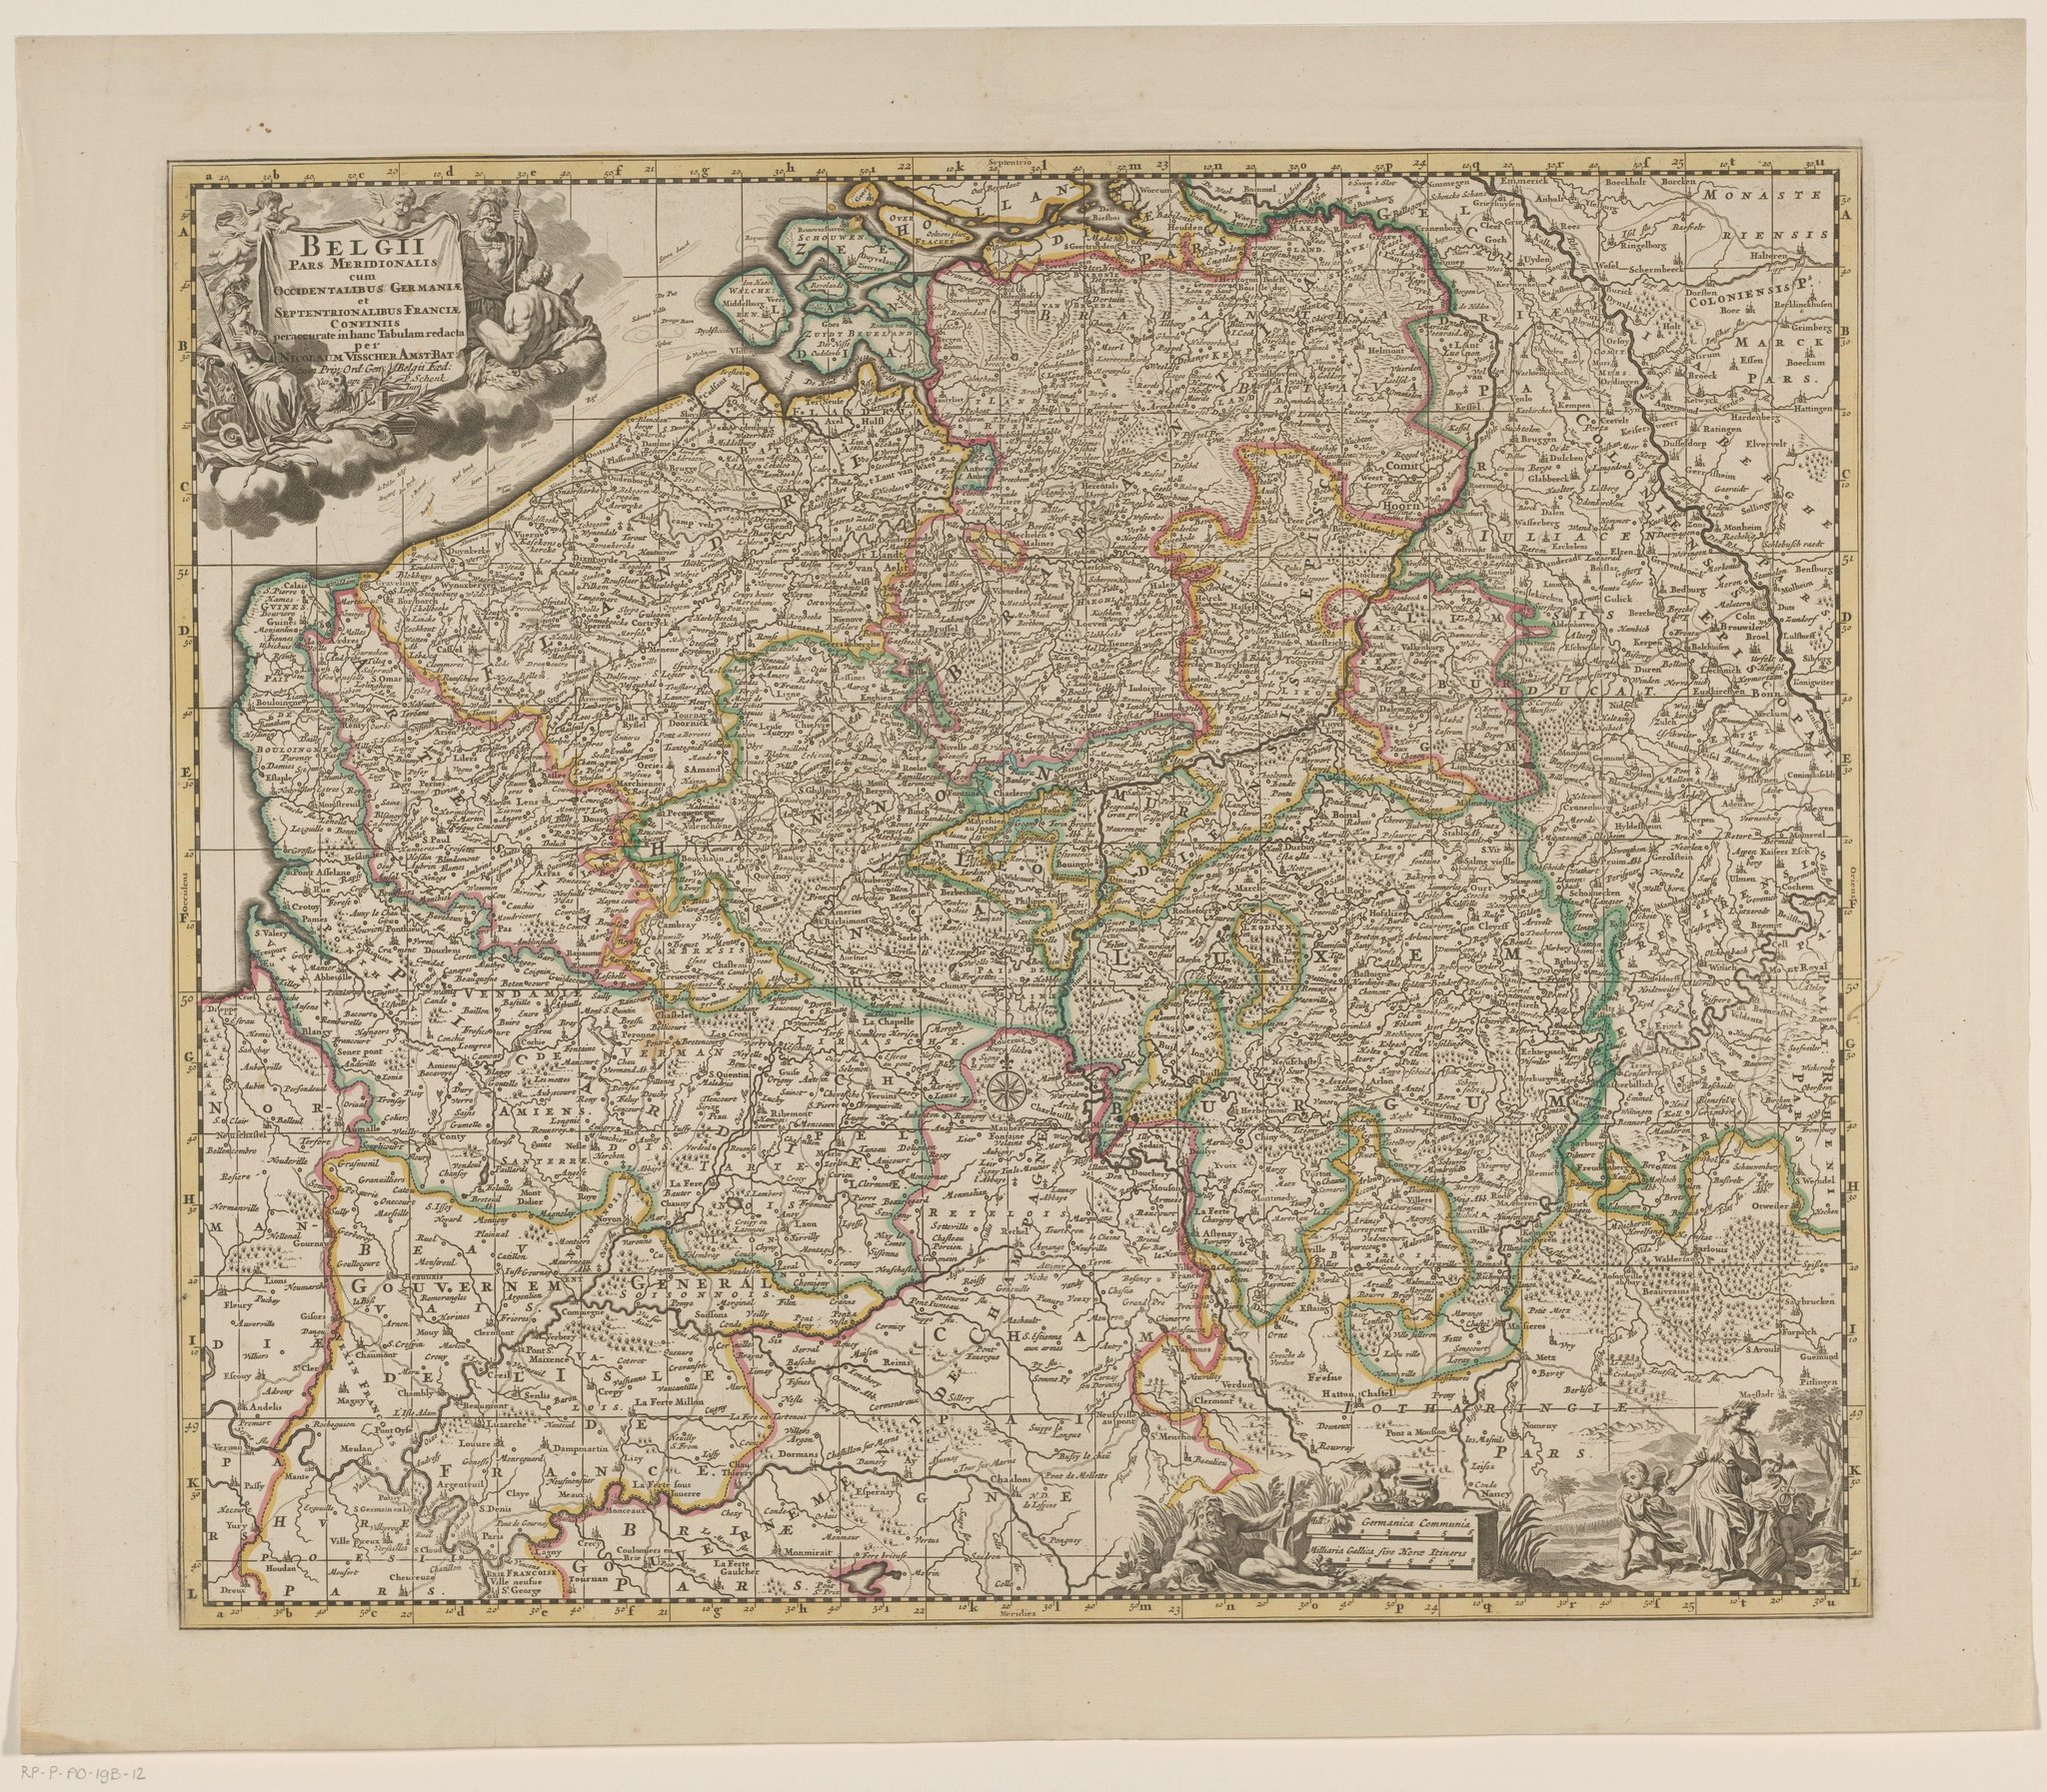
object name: print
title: Belgii pars meridionalis cum occidentalibus Germaniae (...)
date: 1677-1720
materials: paper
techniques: engraving, hand coloring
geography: amsterdam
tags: maps of separate countries or regions, river personified, 'fiumi' (ripa) - hh - ideal landscapes, (story of) minerva (pallas, athena), attributes of minerva, armorial bearing, heraldry, southern netherlands, belgium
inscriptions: collector's mark: Lugt 2228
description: Kaart van de Zuidelijke Nederlanden. Linksboven de titelcartouche. Rechtsonder twee schaalstokken: 5 Mill Germanica Communia / 8 Milliaria Gallica sive Horae Itineris. De kaart is voorzien van een zoekrooster en een gradenverdeling langs de randen.